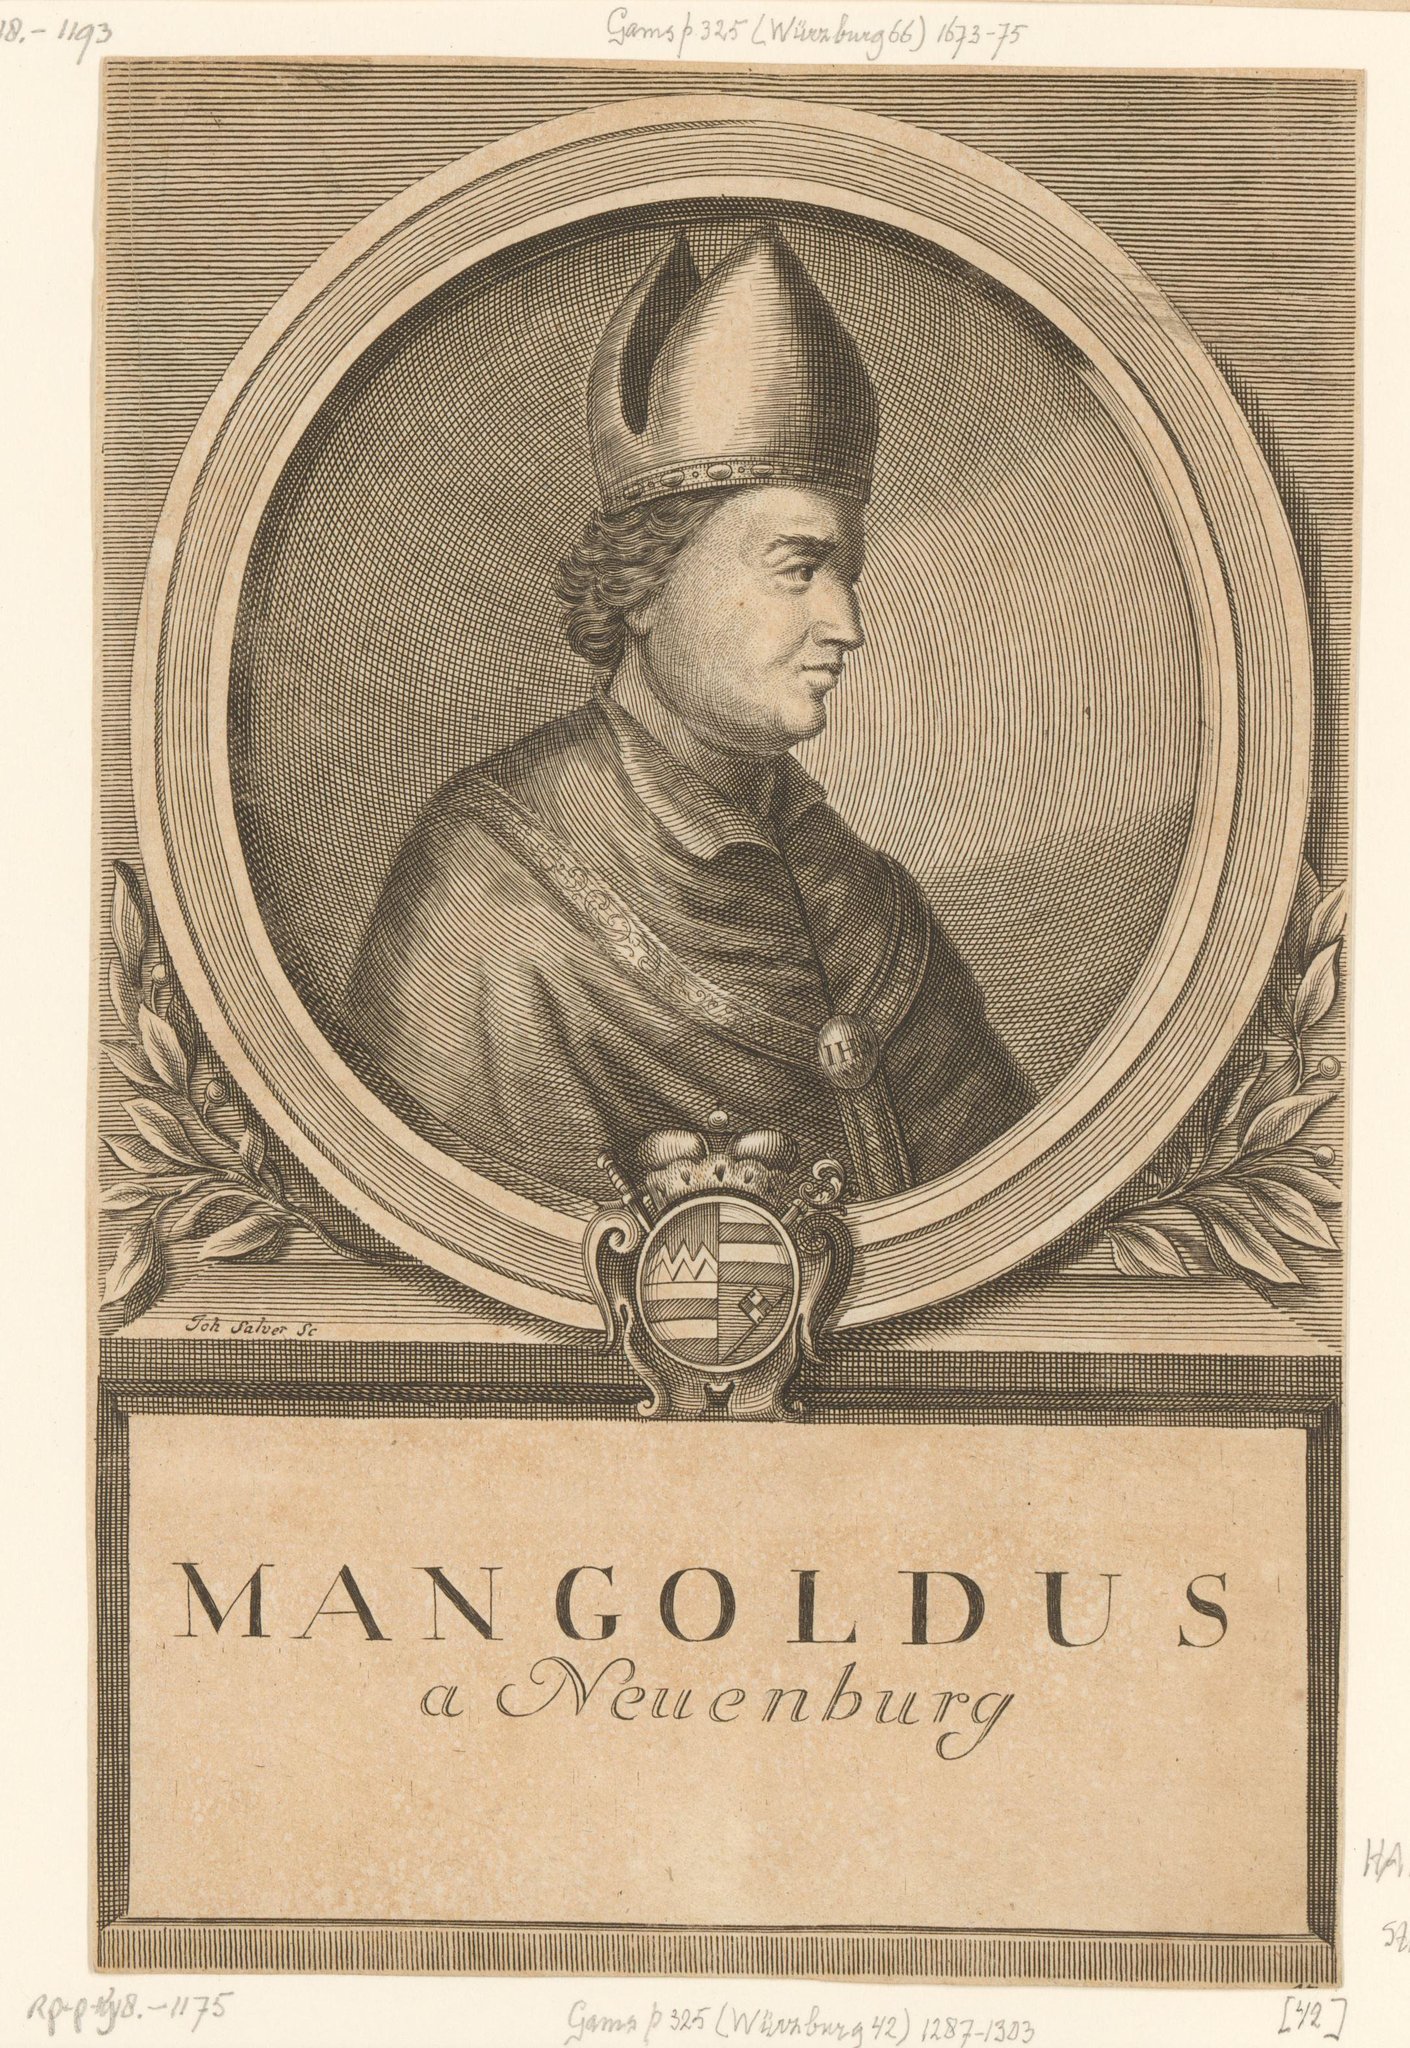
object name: print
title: Portret van Manegold von Neuenburg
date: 1713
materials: paper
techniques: engraving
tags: archbishop, bishop, etc. (roman catholic), theologian, historical persons, armorial bearing, heraldry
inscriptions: collector's mark: Lugt 2233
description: Prent ook gebruikt in: Ludewig, Johann Peter von. Geschicht-Schreiber von dem Bischoffthum Wirtzburg. Frankfurt am Main: Thomas Fritsch, 1713.